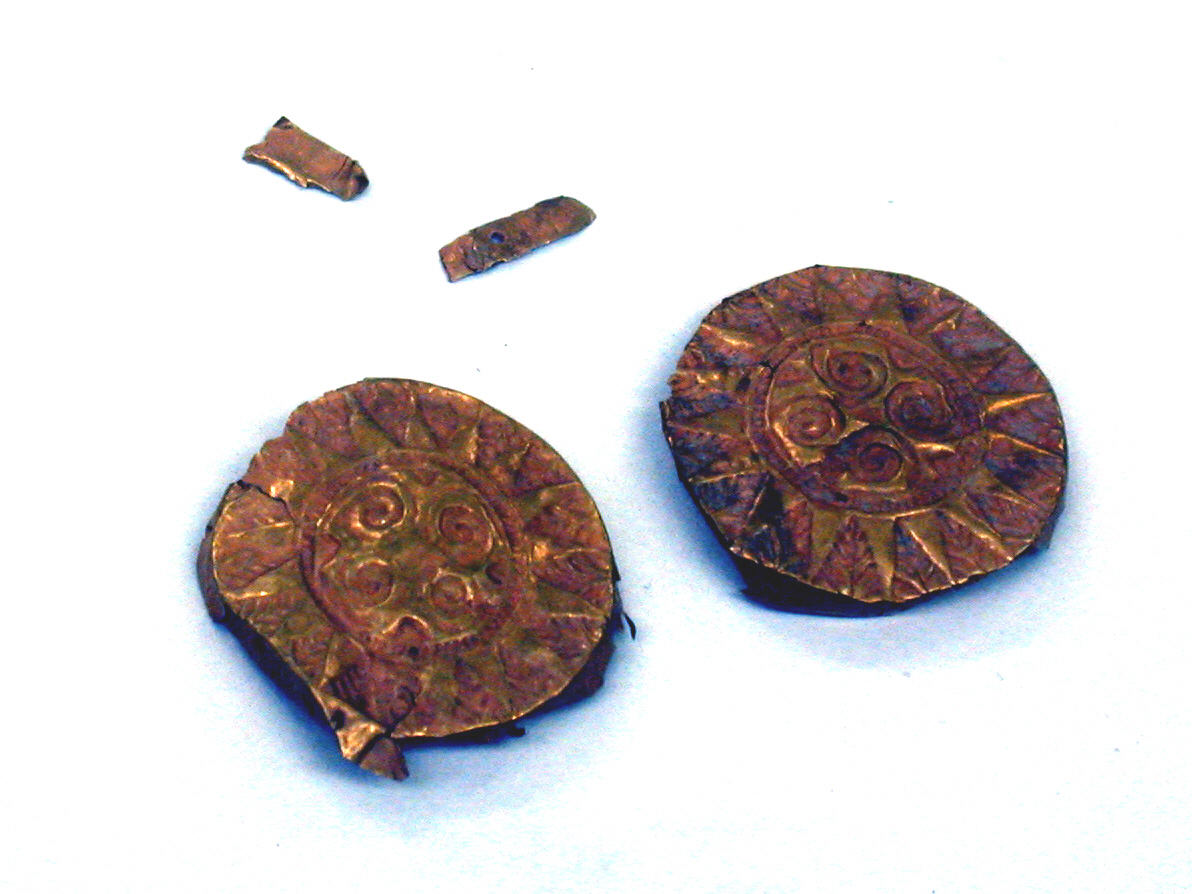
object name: ear ornament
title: Ear Ornament ?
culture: visayas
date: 1301-1500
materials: gold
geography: philippines